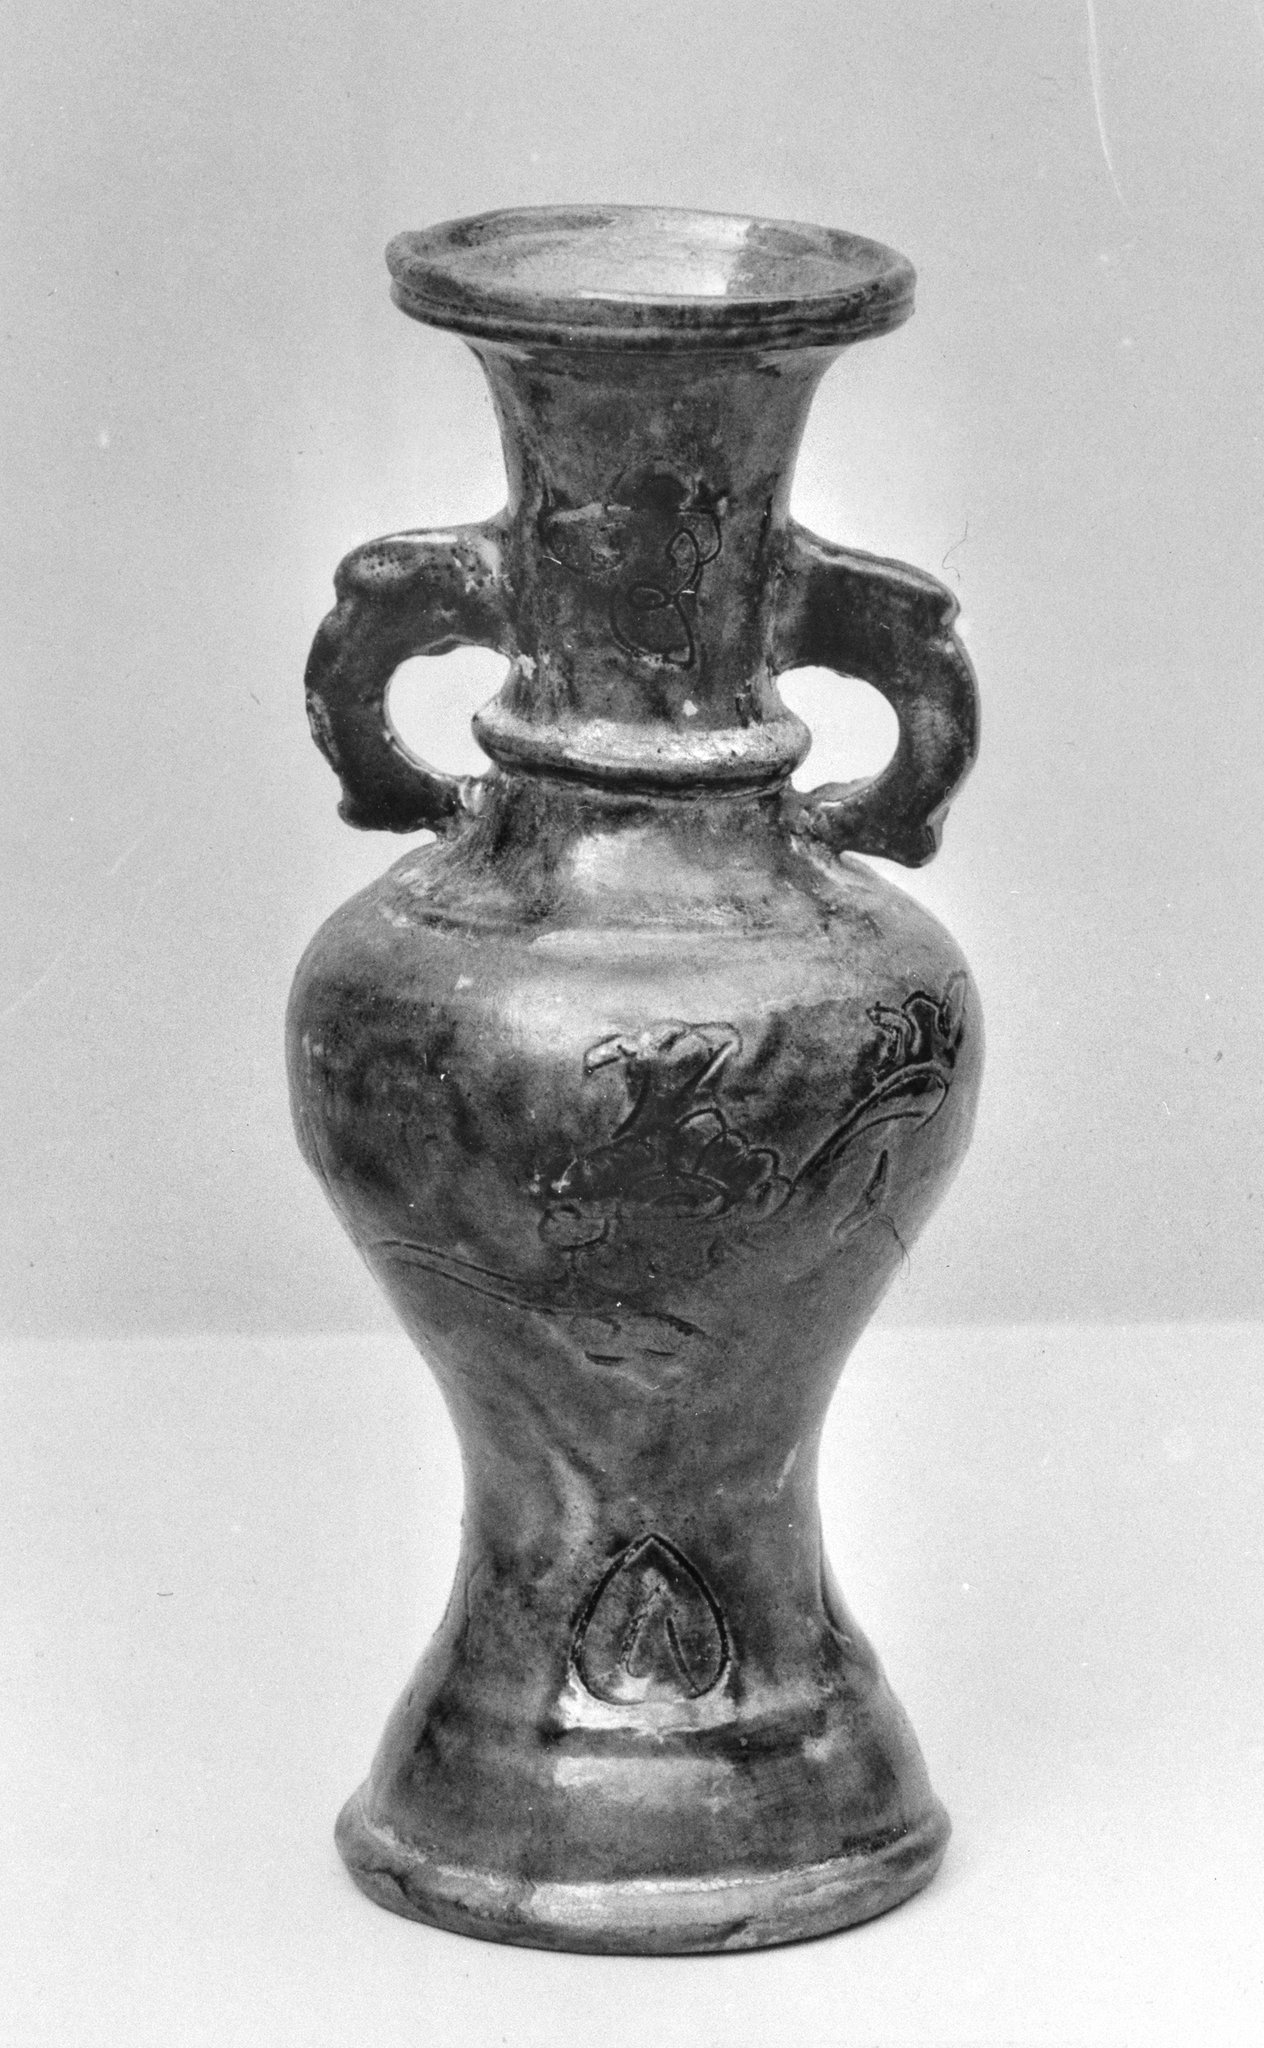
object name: vase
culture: chinese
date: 1368-1644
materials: pottery